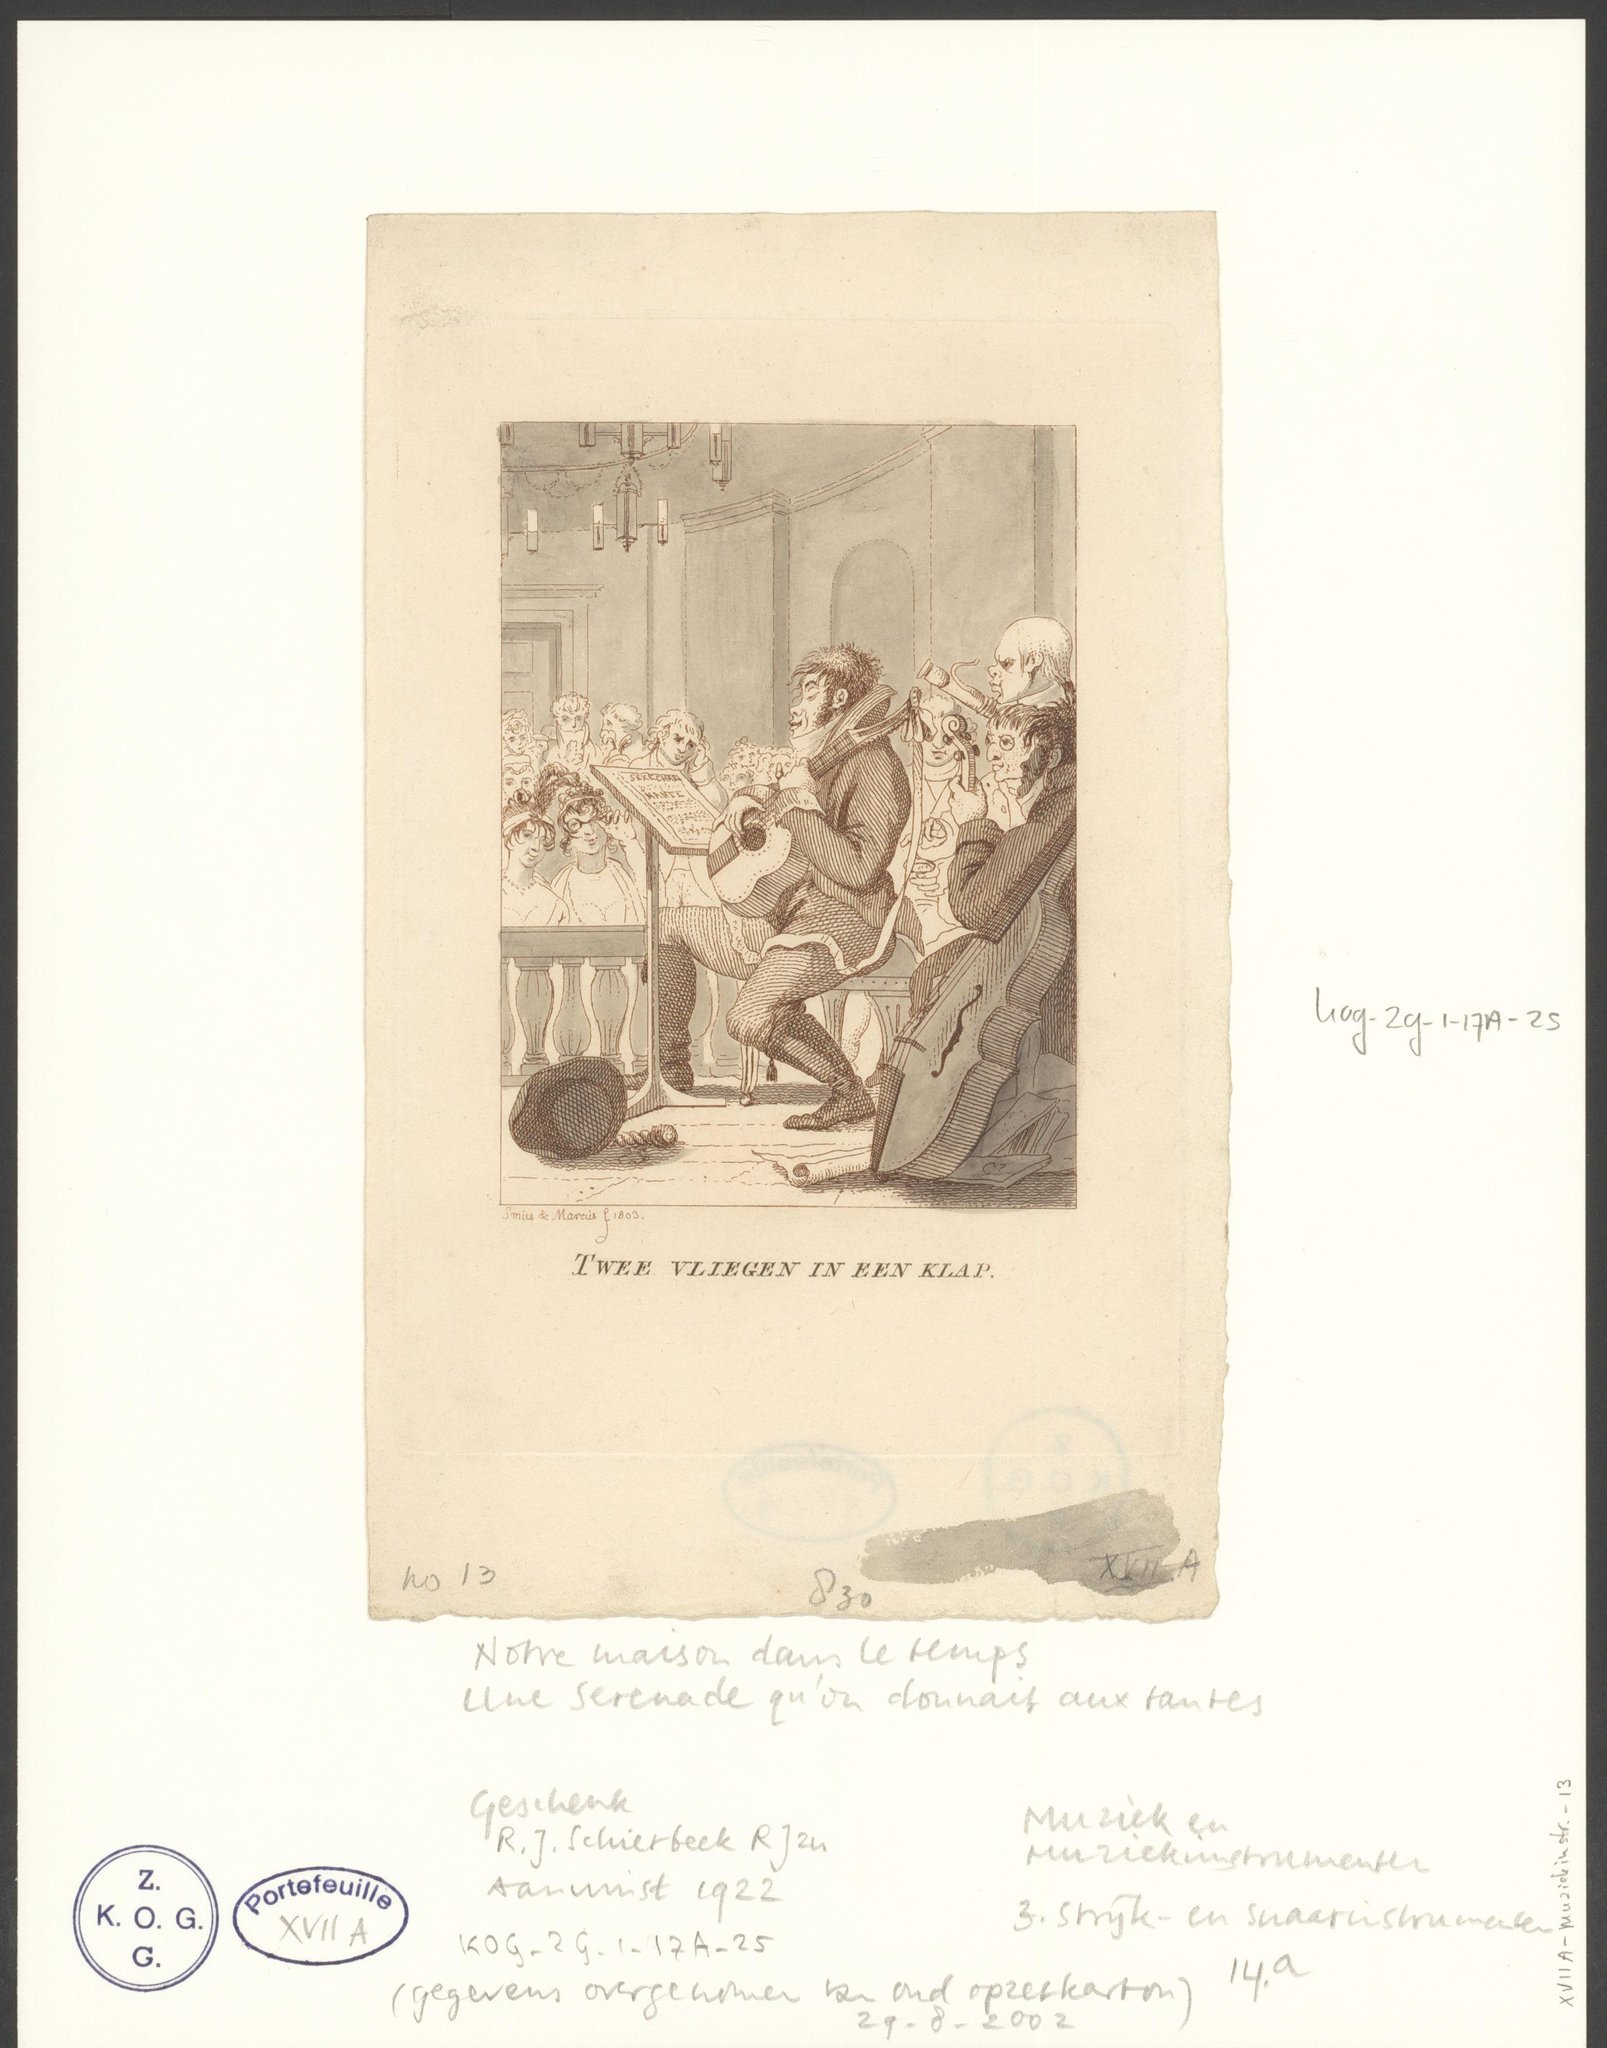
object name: cartoon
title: Concertzaal Felix Meritis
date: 1803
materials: ink, paper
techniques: brush, etching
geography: netherlands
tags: small group of musicians, chamber orchestra, jazz band, string instruments (plucked)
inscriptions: collector's mark: Lugt 1641, stamp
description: Een groep muzikanten treedt op in de concertzaal van Felix Meritis te Amsterdam. Prominent afgebeeld is een zelfgenoegzame muzikant die met het spelen van het stuk 'Sexe Charmante' de vrouwelijke toehoorders in de zaal bekoort. Onderdeel van een serie van acht prenten met als doel contrasten van het toenmalige werkelijke leven ca. 1800 met de beschaafde wereld (beau-monde) te tonen. Onderwerpsrubrieken binnen de Atlas Zeden en Gewoonten: Muziek en muziekinstrumenten: Strijk- en snaarinstrumenten.